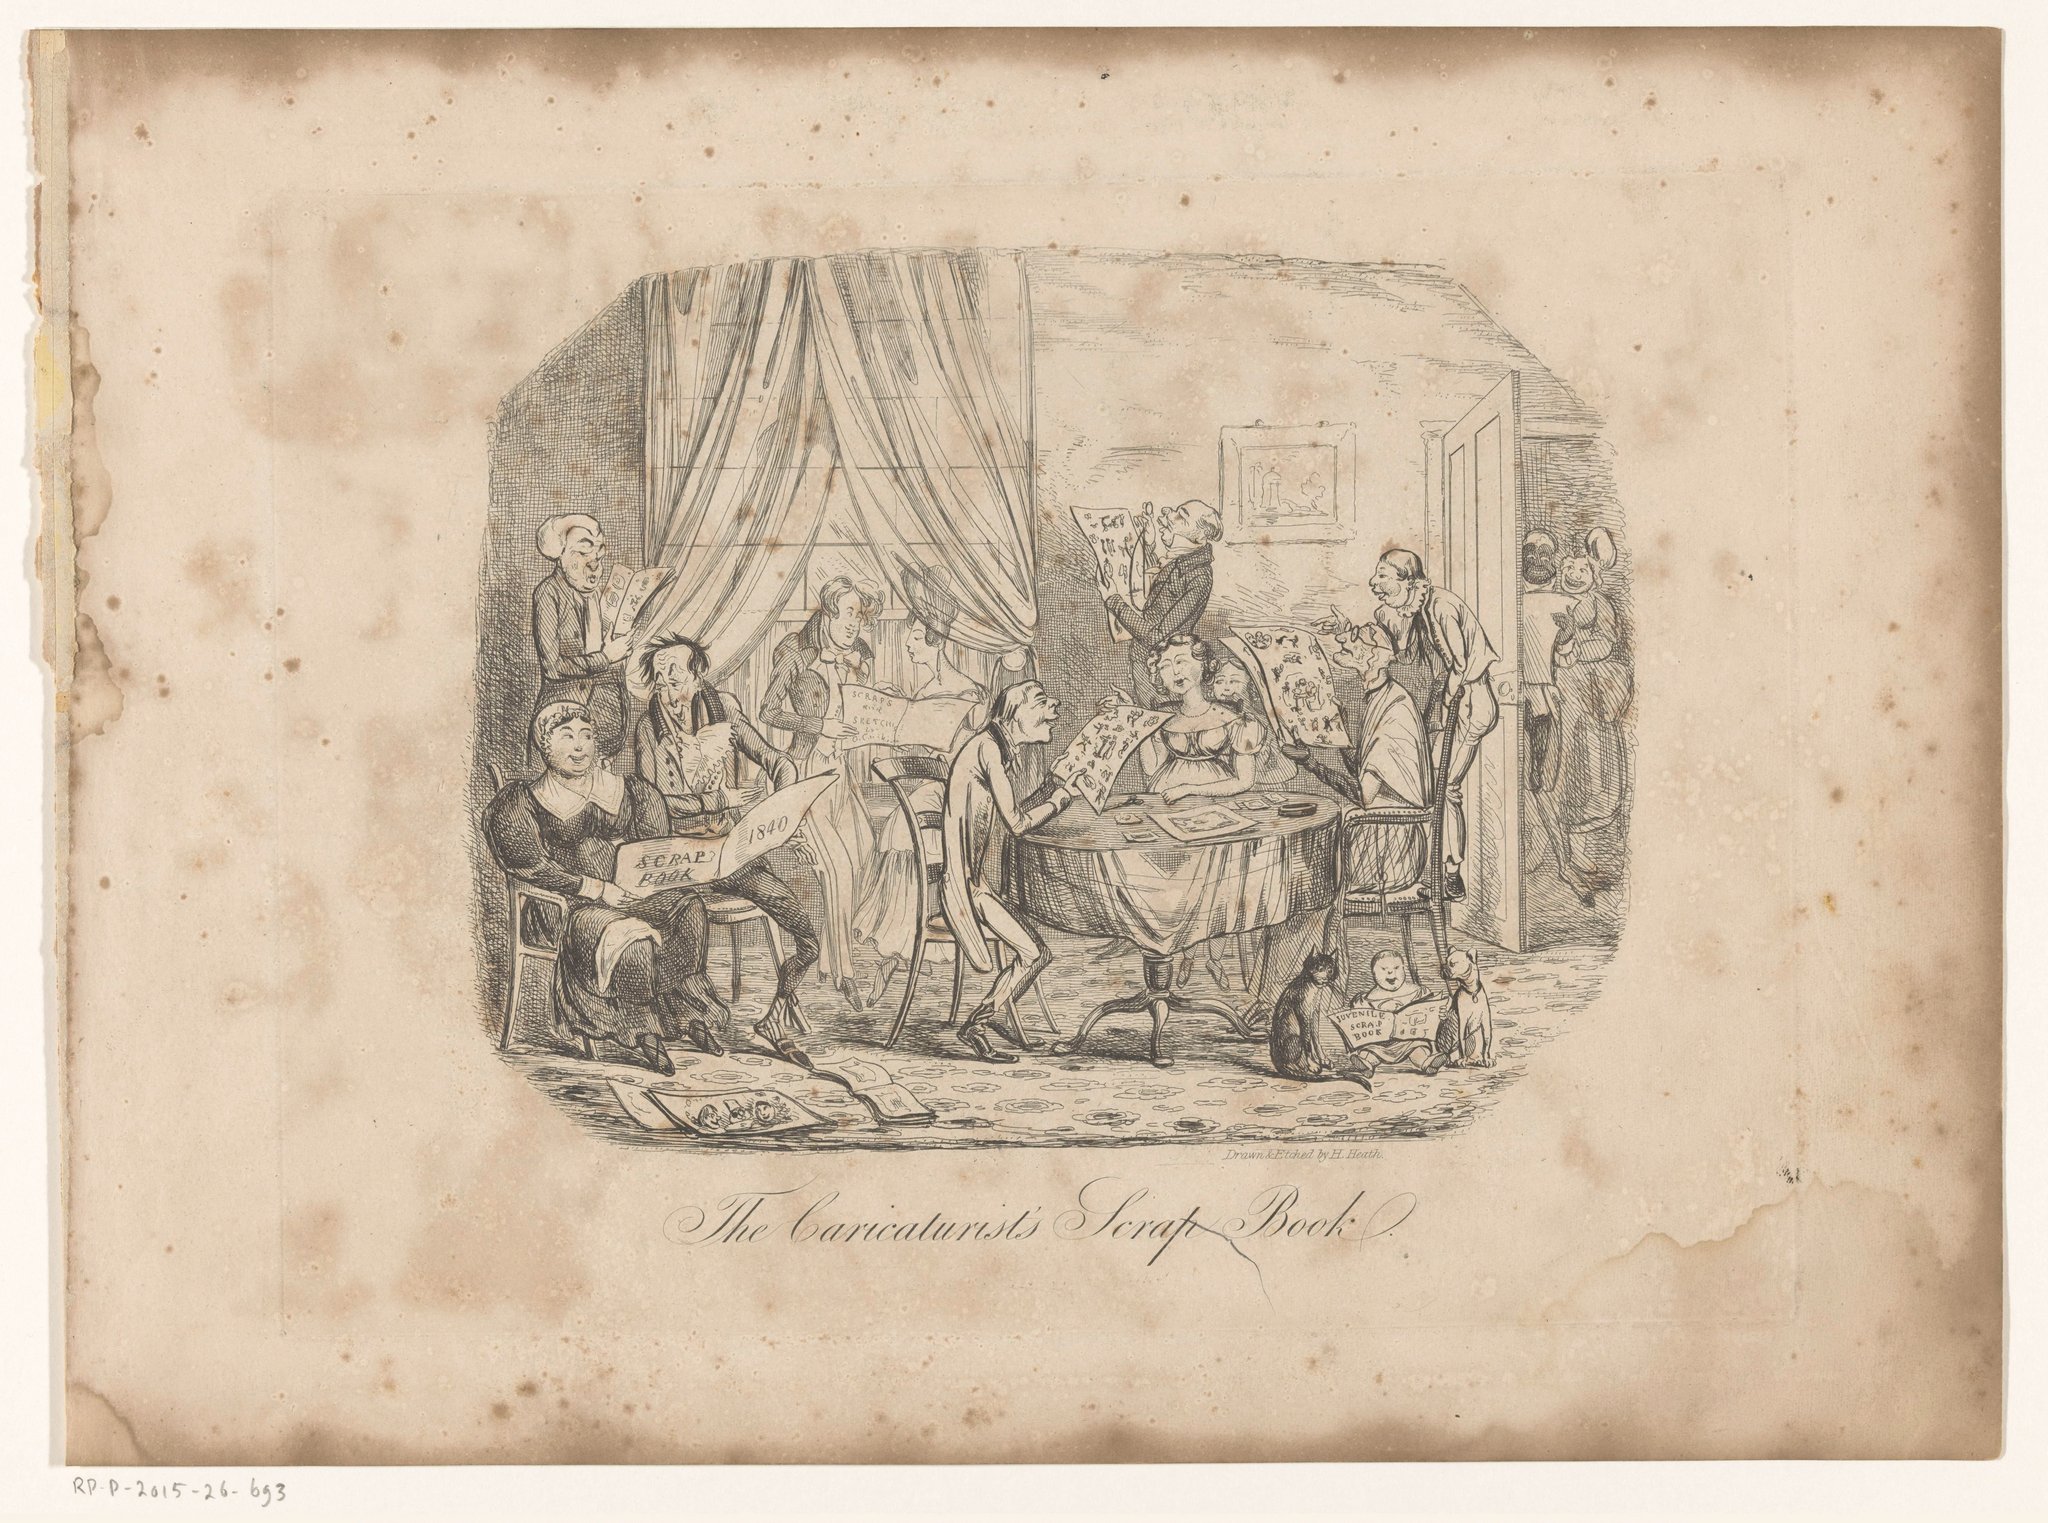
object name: titelblad, titelpagina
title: Titelpagina voor: Henry Heath, The Caricaturist's Scrap Book, 1840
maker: henry heath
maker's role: print maker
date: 1840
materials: paper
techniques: etching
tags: caricatures (human types), print, e.g.: engraving, etching, lithograph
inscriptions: collector's mark: Lugt 2228, collector's mark: Lugt 4779